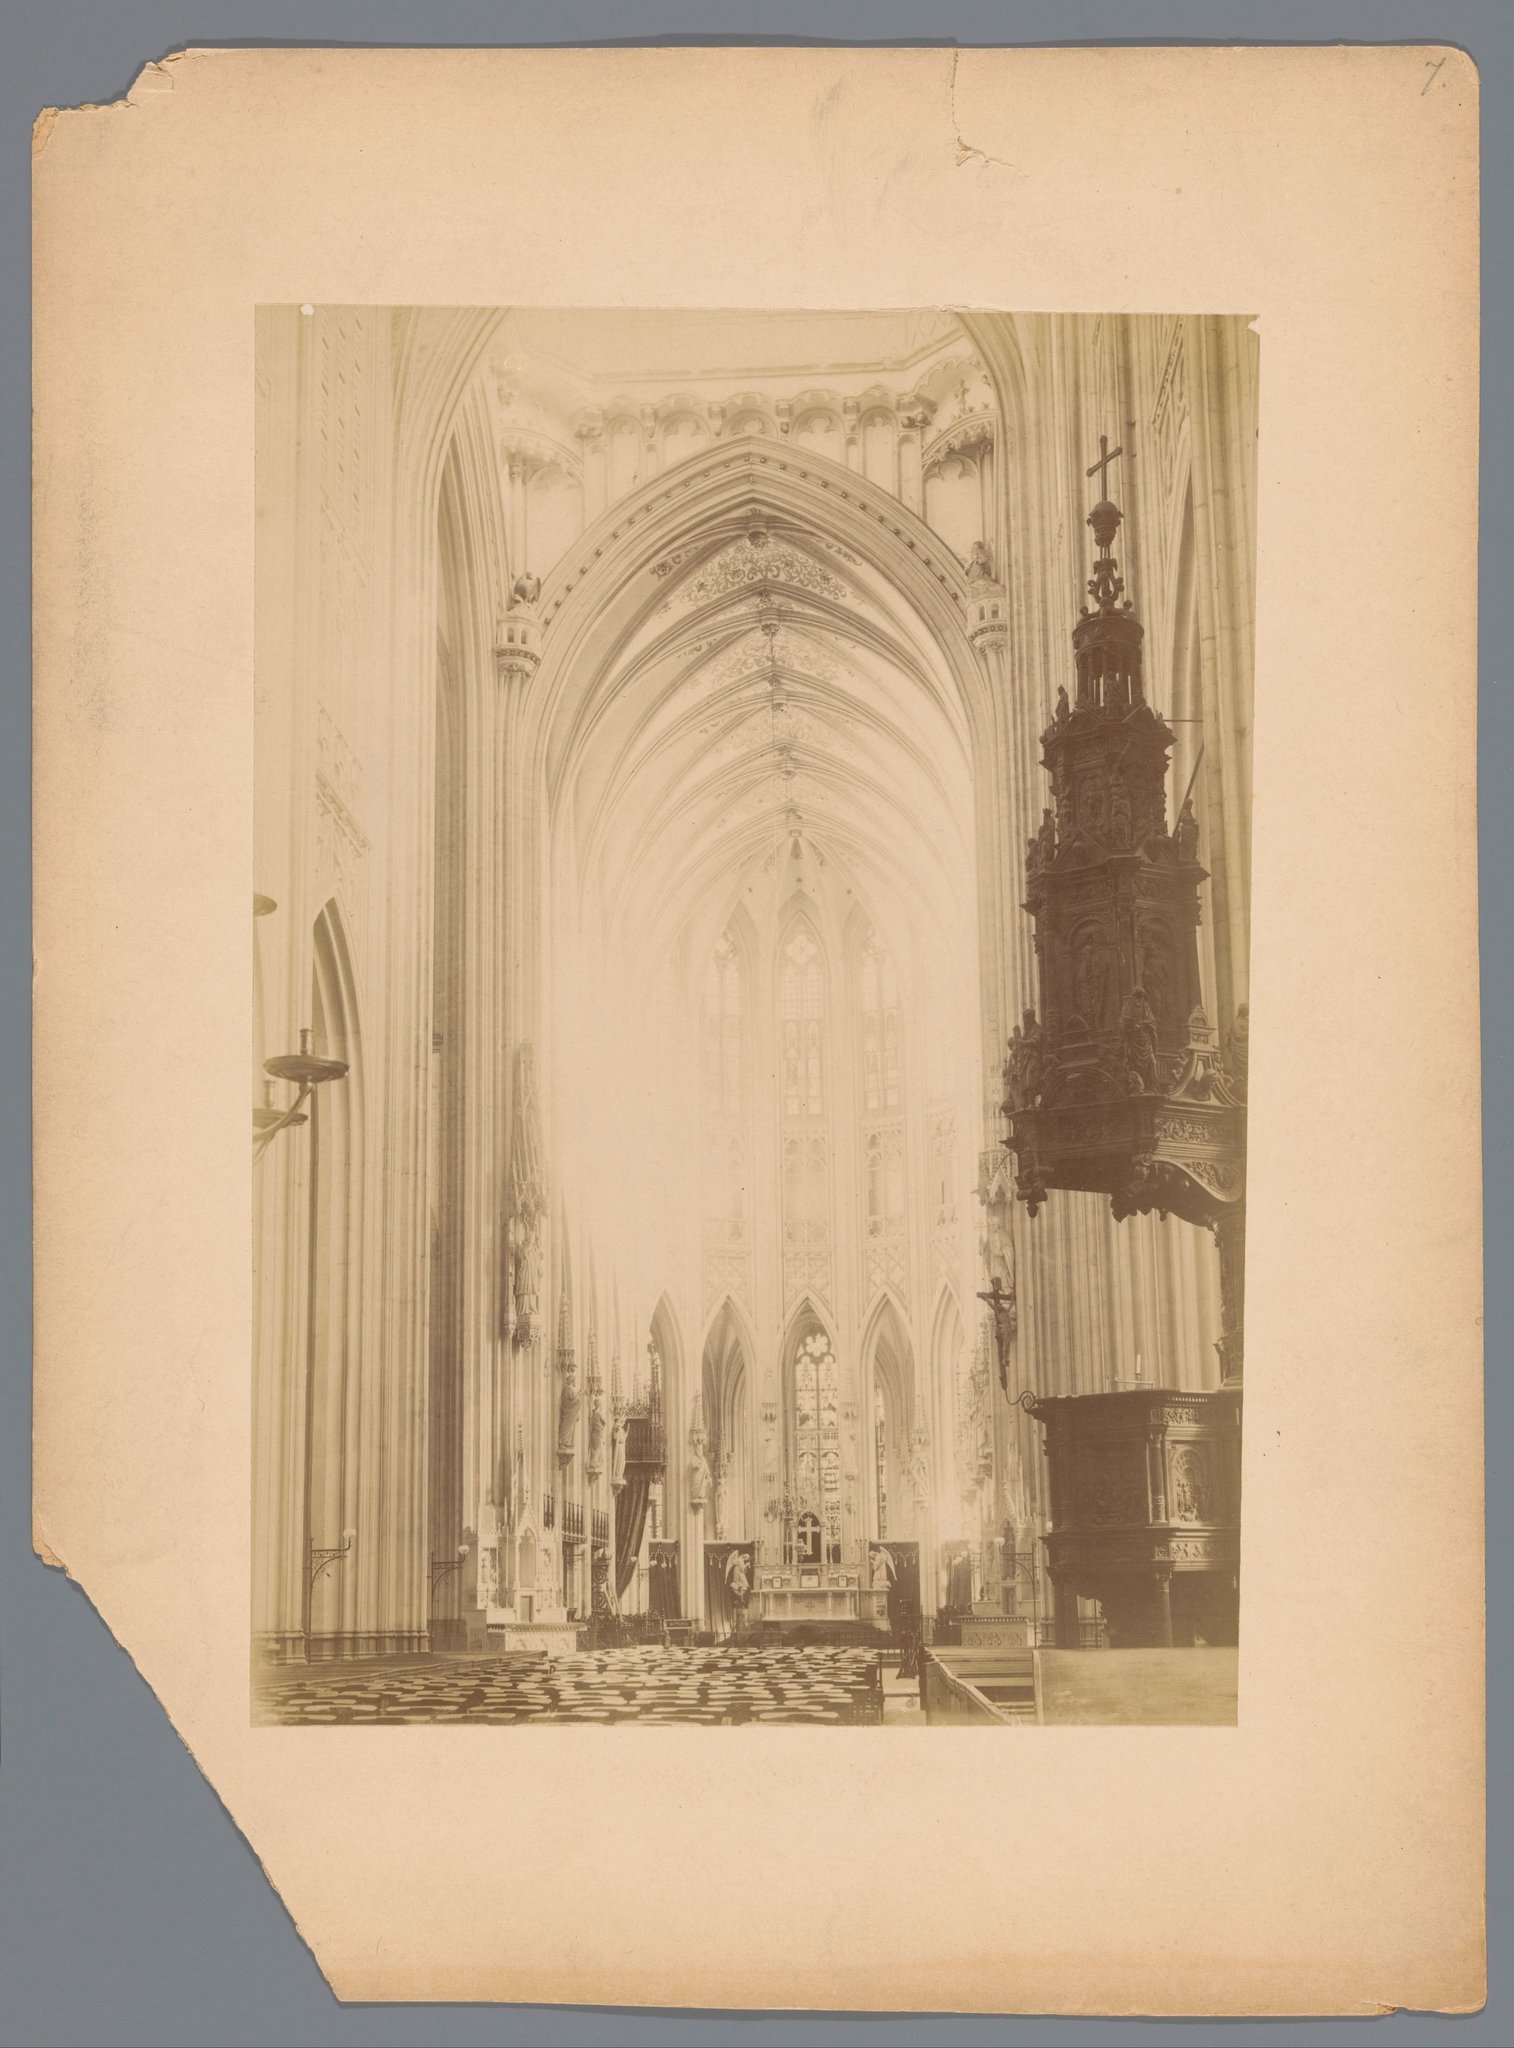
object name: photograph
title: Exterieur van een rooms-katholieke kerk in Nederland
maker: Anonymous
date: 1900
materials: cardboard, photographic support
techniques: albumen print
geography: netherlands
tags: church (exterior), parts of church exterior and annexes: tower, netherlands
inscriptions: inscription: ‘[...] Noord-westzijde der RK Kerk nu afgebroken’, collector's mark: Lugt 3937